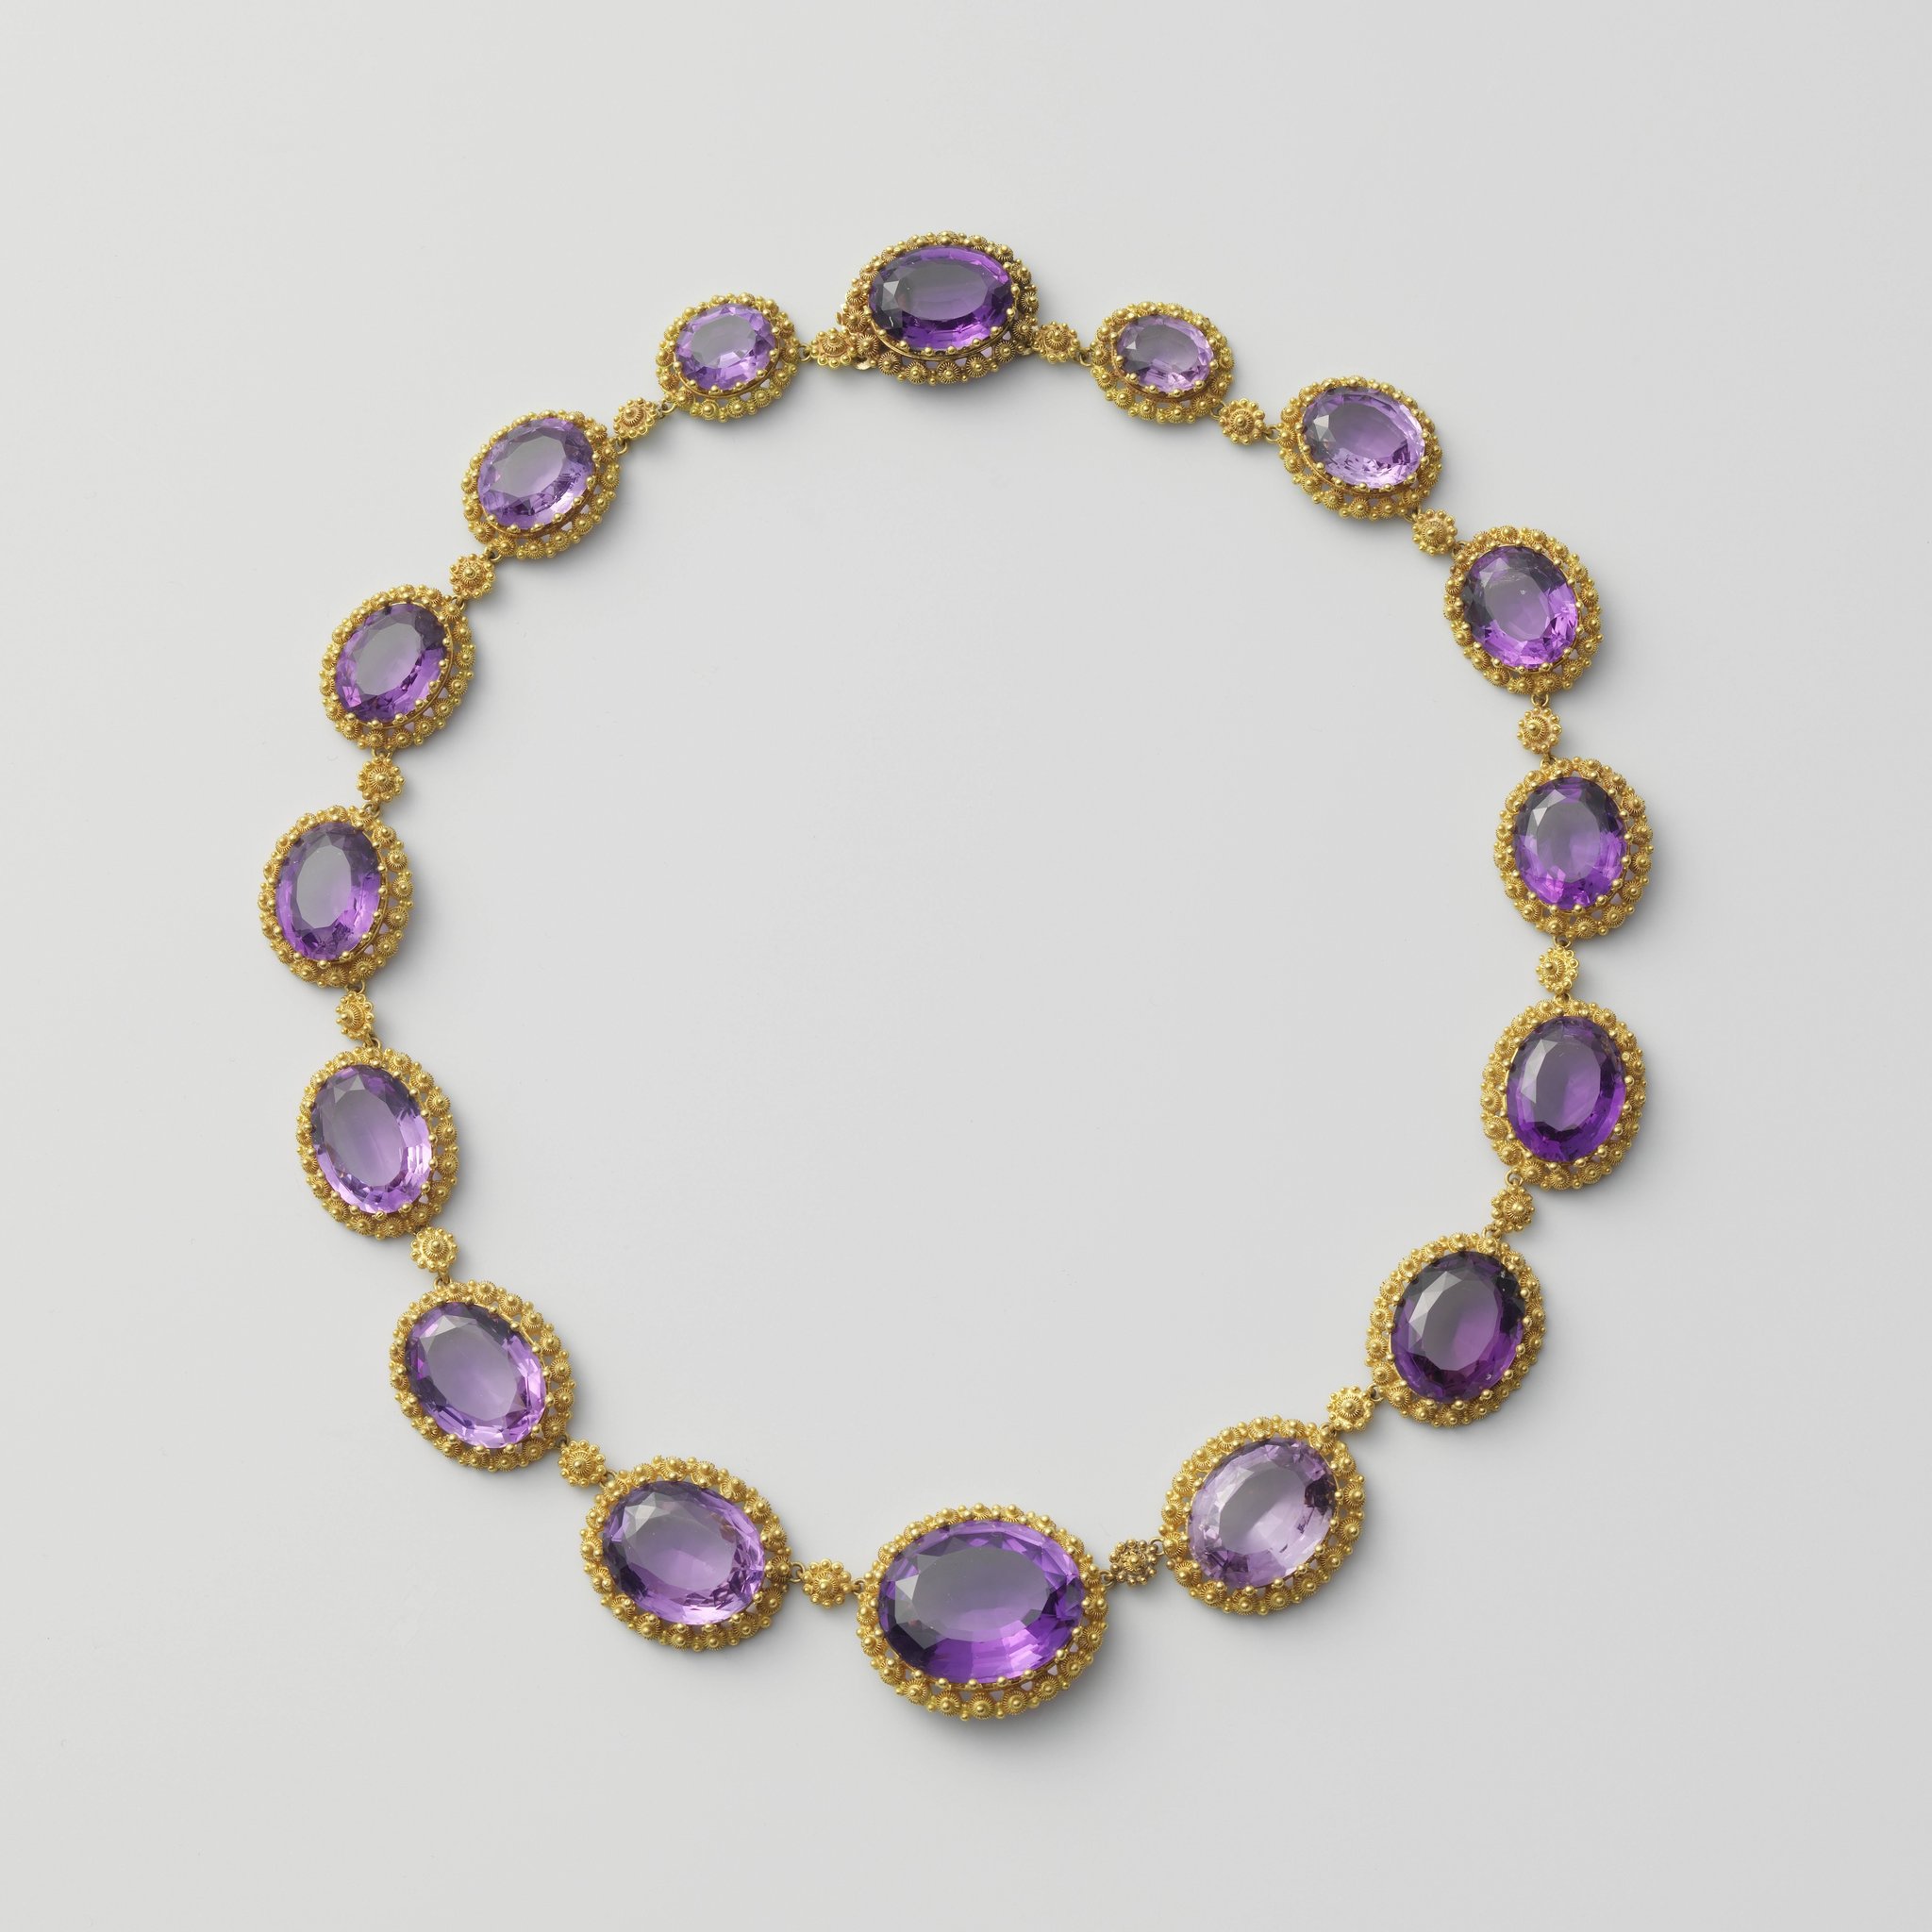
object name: jewellery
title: Collier van goud en amethist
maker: jean baptiste bonnard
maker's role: goldsmith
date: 1824-1829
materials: gemstone, gold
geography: amsterdam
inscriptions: alloy mark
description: Parure. Gold and amethyst. Amsterdam, c. 1824 - 1829, by Jean Baptiste Bonnard.